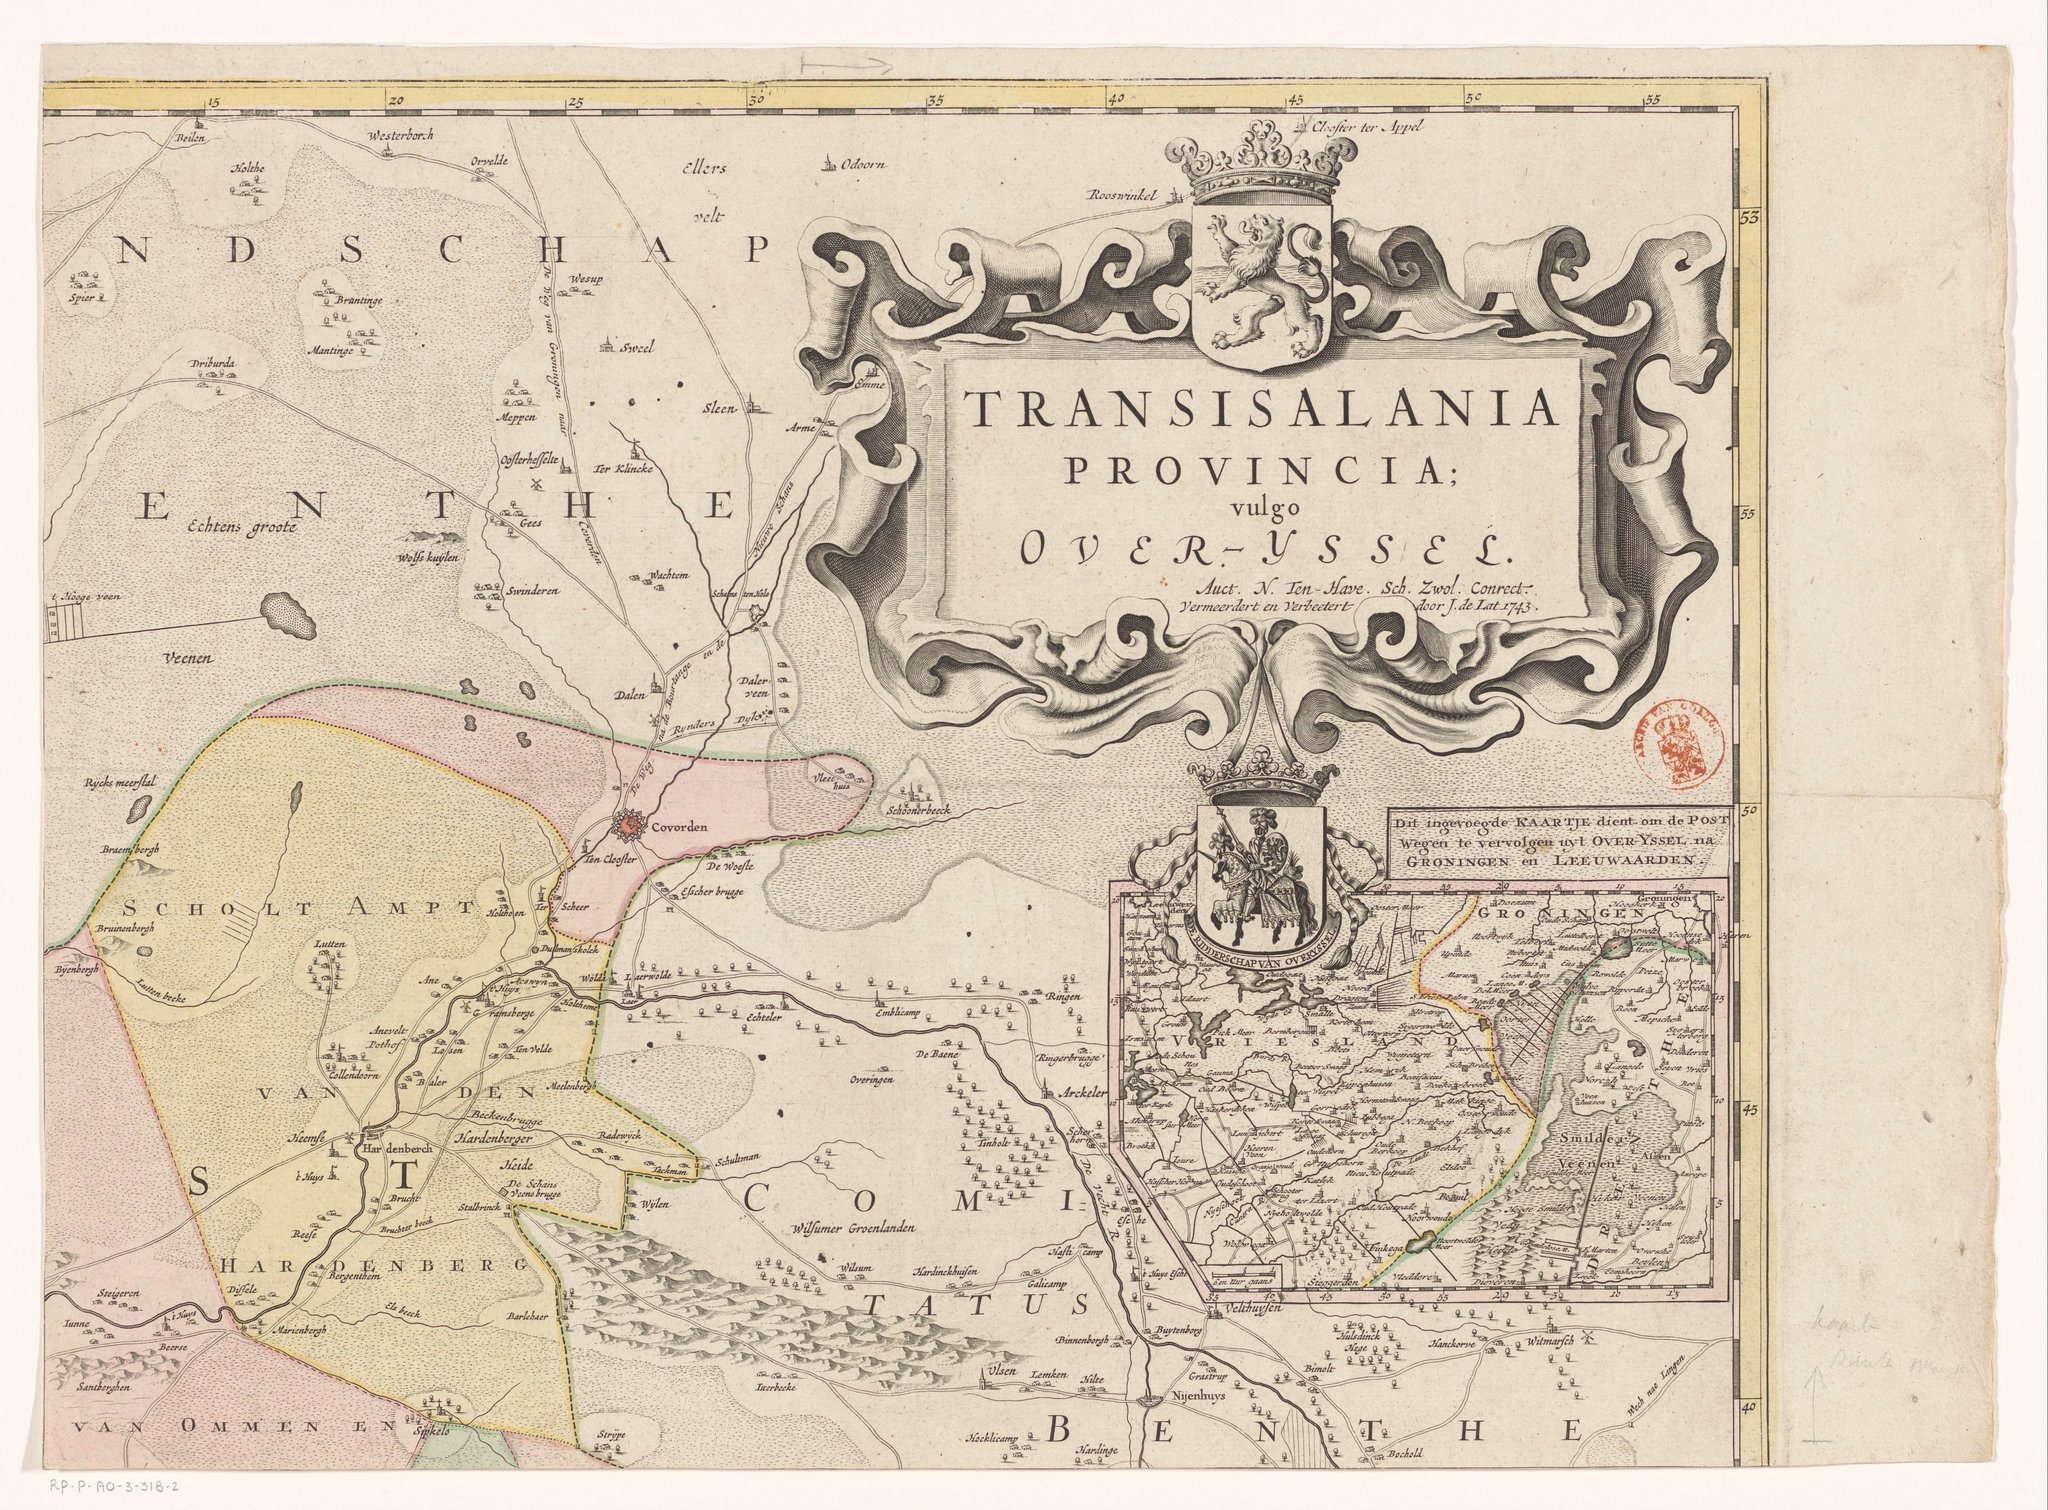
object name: print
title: Kaart van Overijssel (deel rechtsboven)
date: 1743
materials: paper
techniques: engraving, hand coloring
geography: deventer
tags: coat of arms (as symbol of the state, etc.), maps of separate countries or regions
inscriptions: collector's mark: Lugt 19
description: Prent ook gebruikt in: Nieuwe atlas inhoudende de vier gedeeltens der waereld (...). 5 delen. Amsterdam: Covens & Mortier, s.a. [1721-1759].